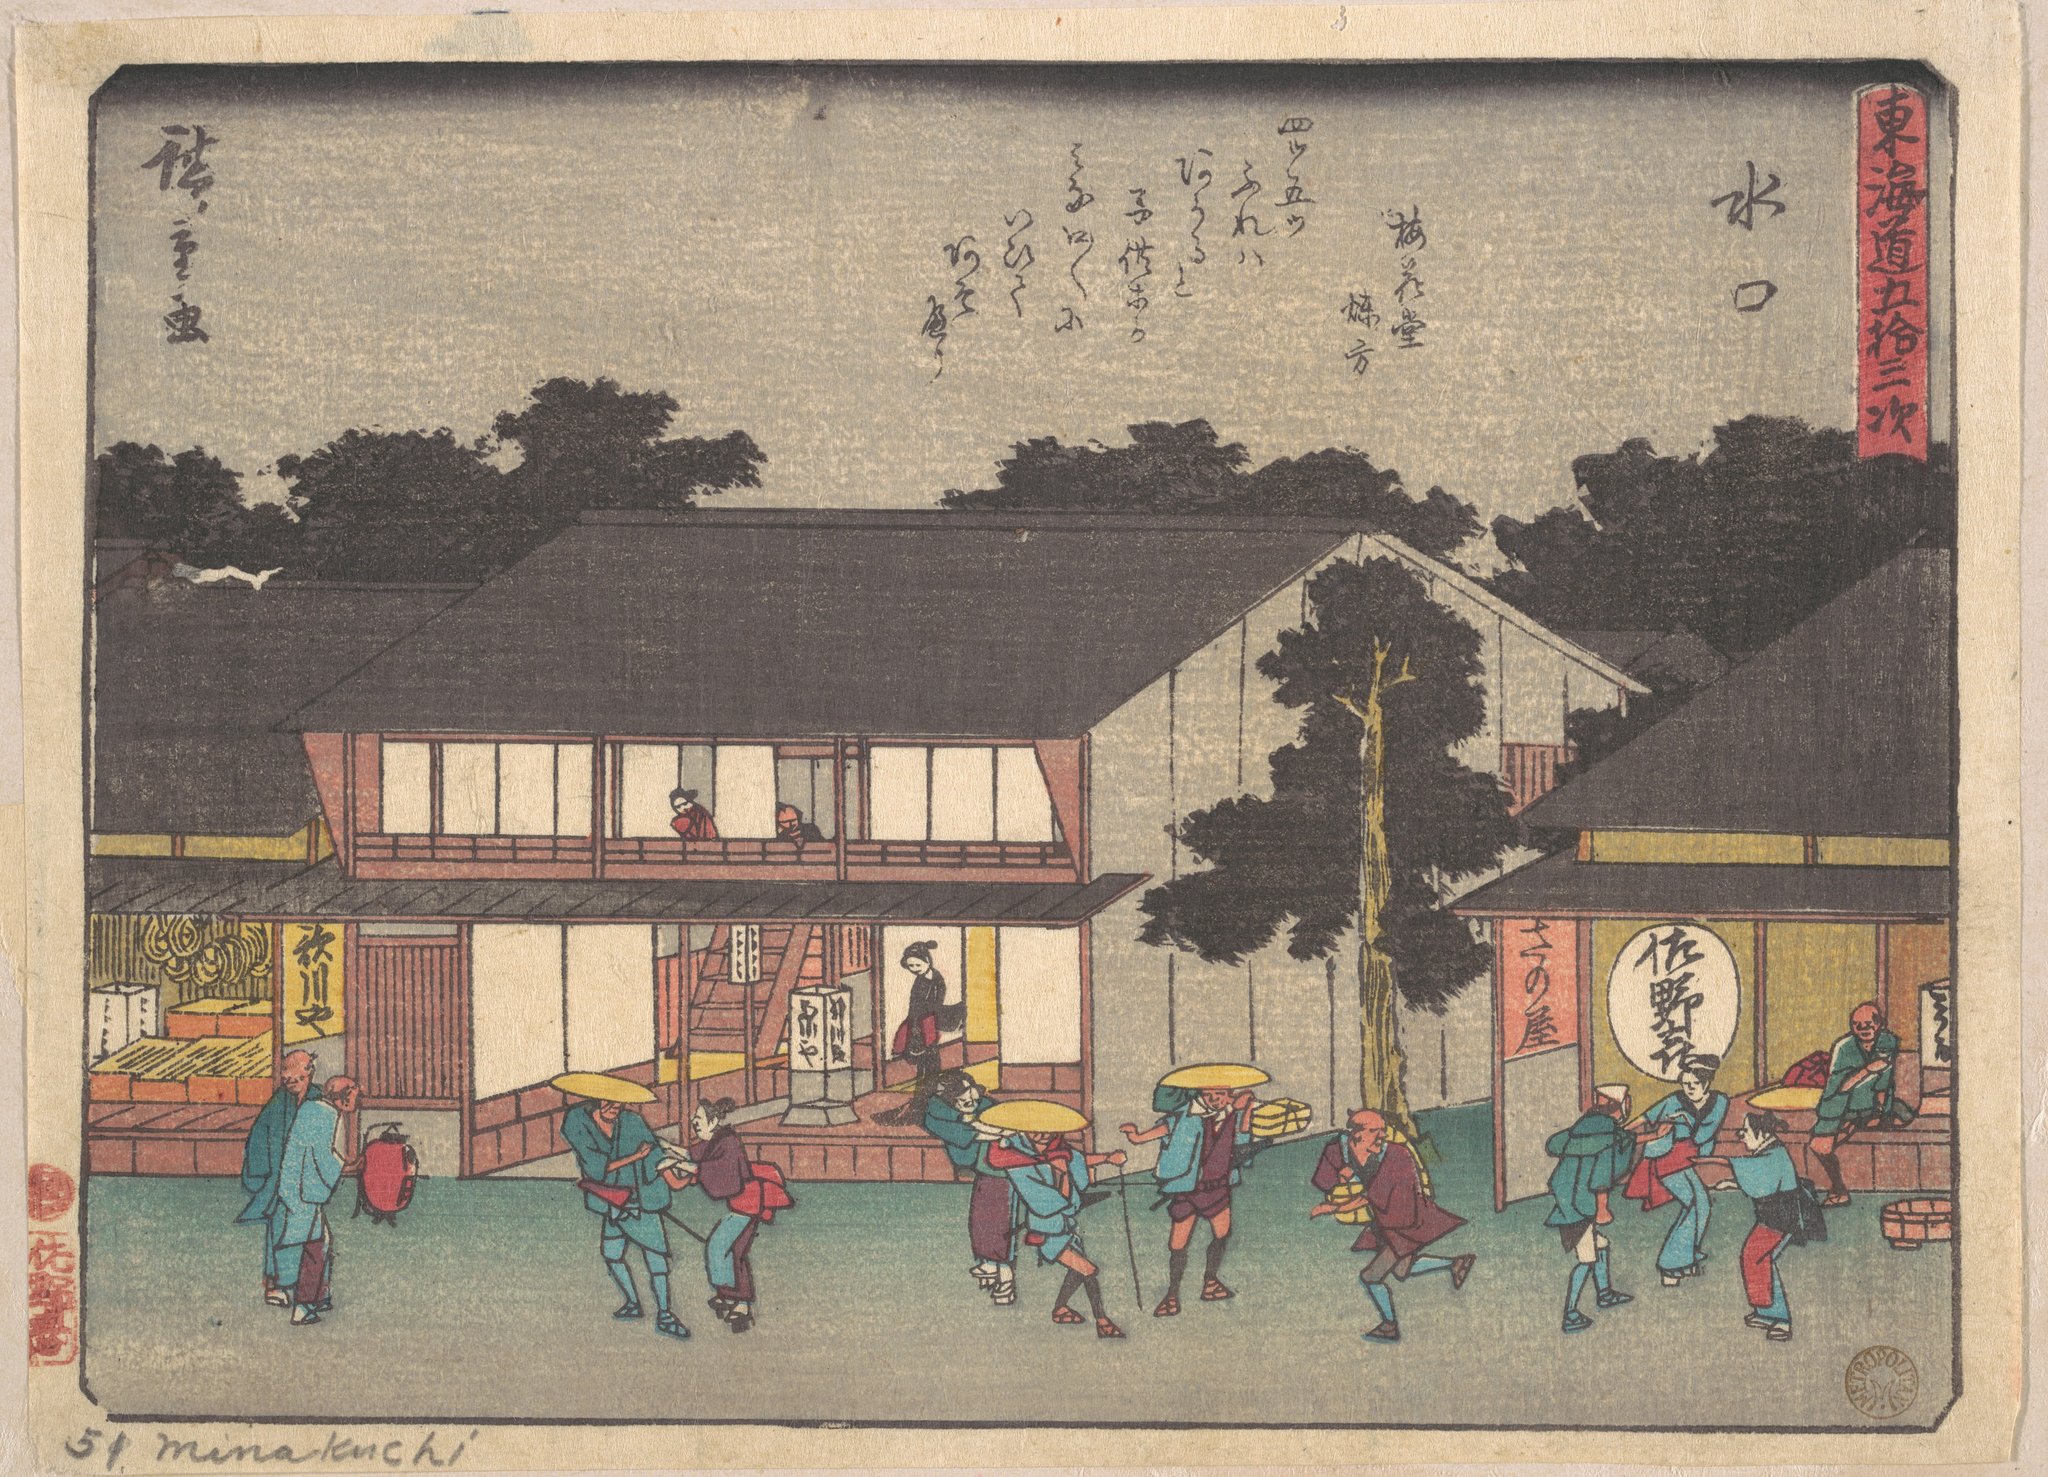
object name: print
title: Mizukuchi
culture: japanese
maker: utagawa hiroshige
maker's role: artist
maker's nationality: japanese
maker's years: 1797-1858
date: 1838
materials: ink, paper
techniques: woodblock print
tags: inns,men,women